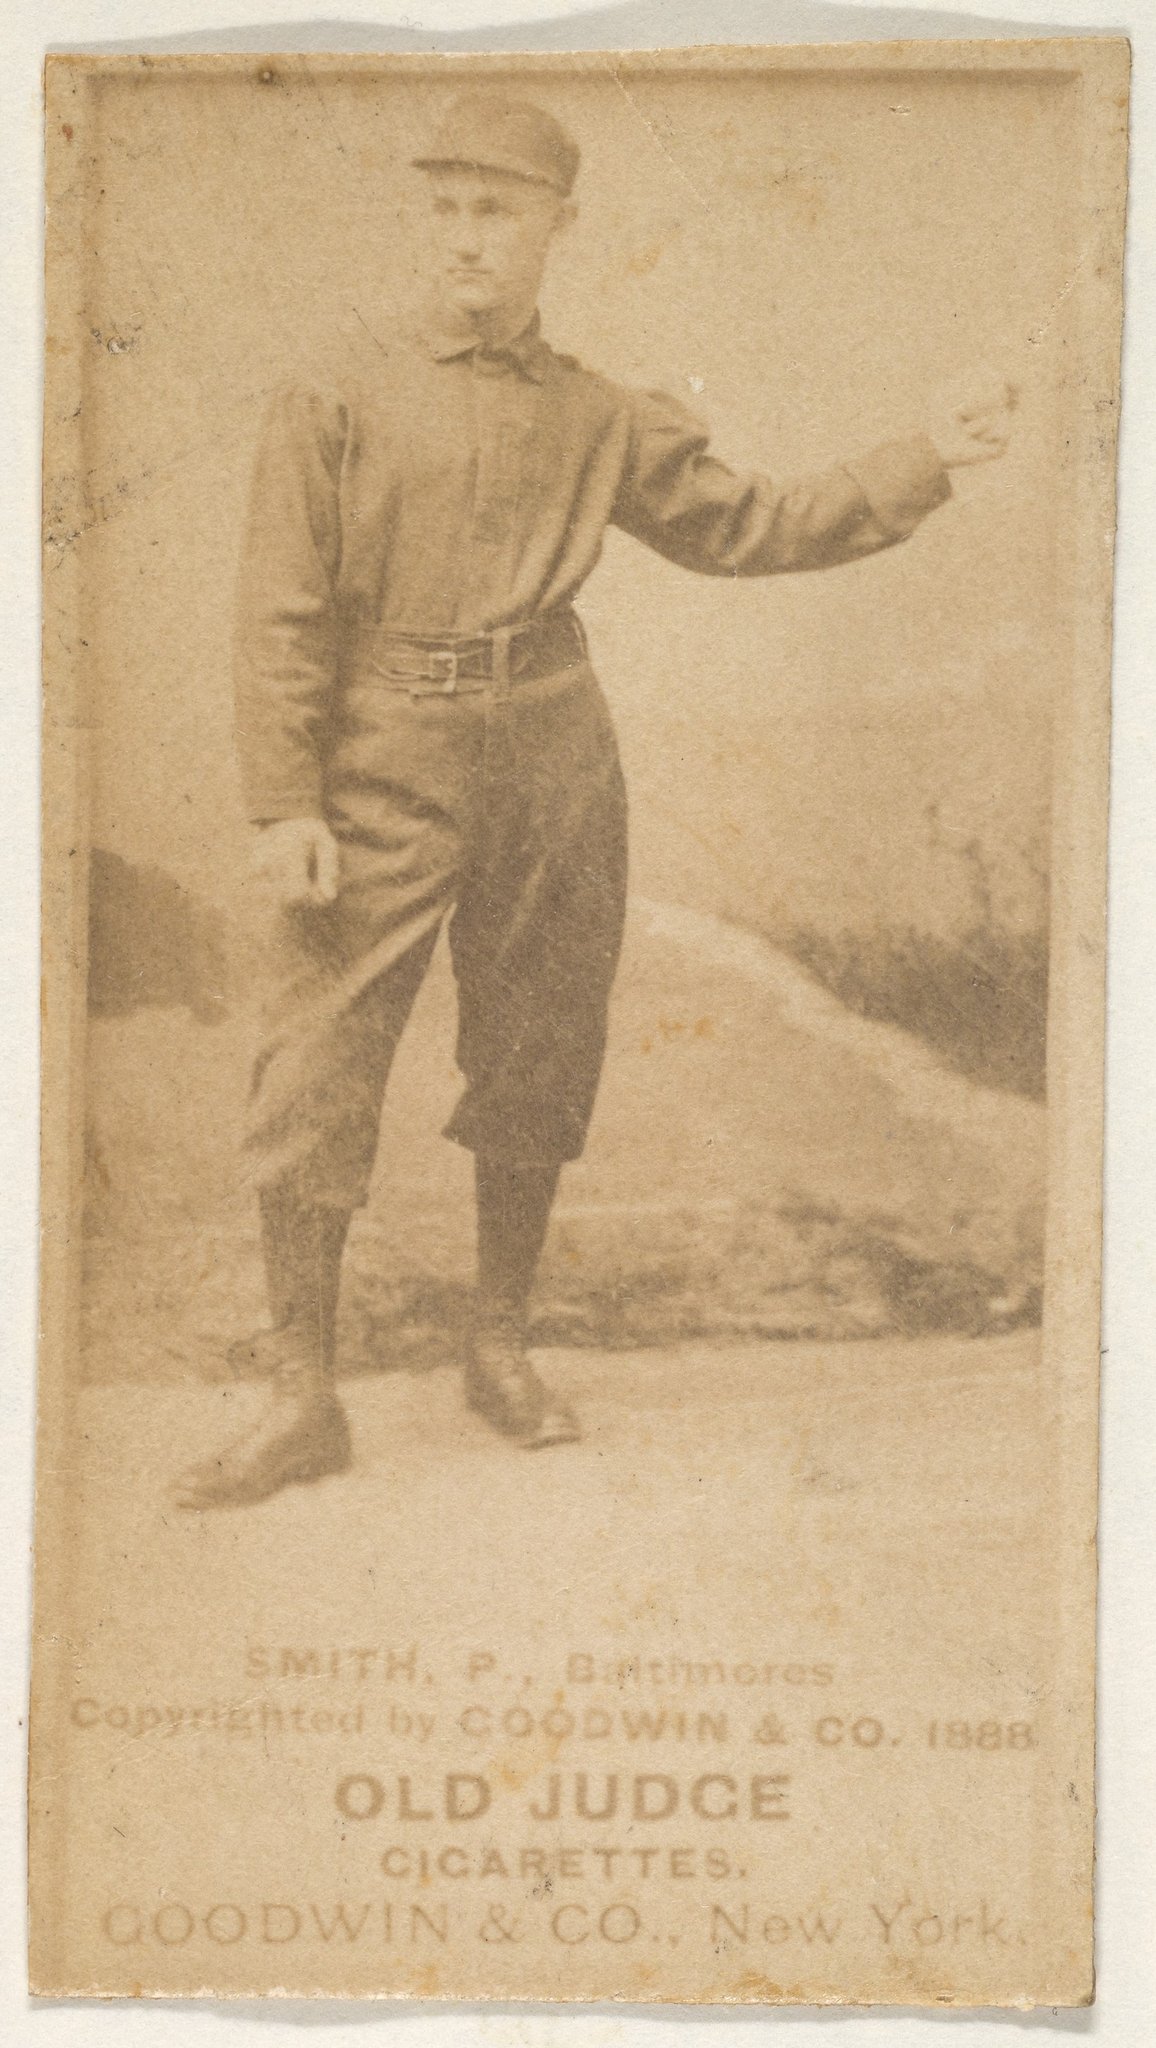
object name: baseball card, photograph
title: Smith, Pitcher, Baltimore Orioles, from the Old Judge series (N172) for Old Judge Cigarettes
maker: goodwin & company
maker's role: publisher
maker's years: 1850-1950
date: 1888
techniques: albumen silver print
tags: men,portraits,baseball,athletes